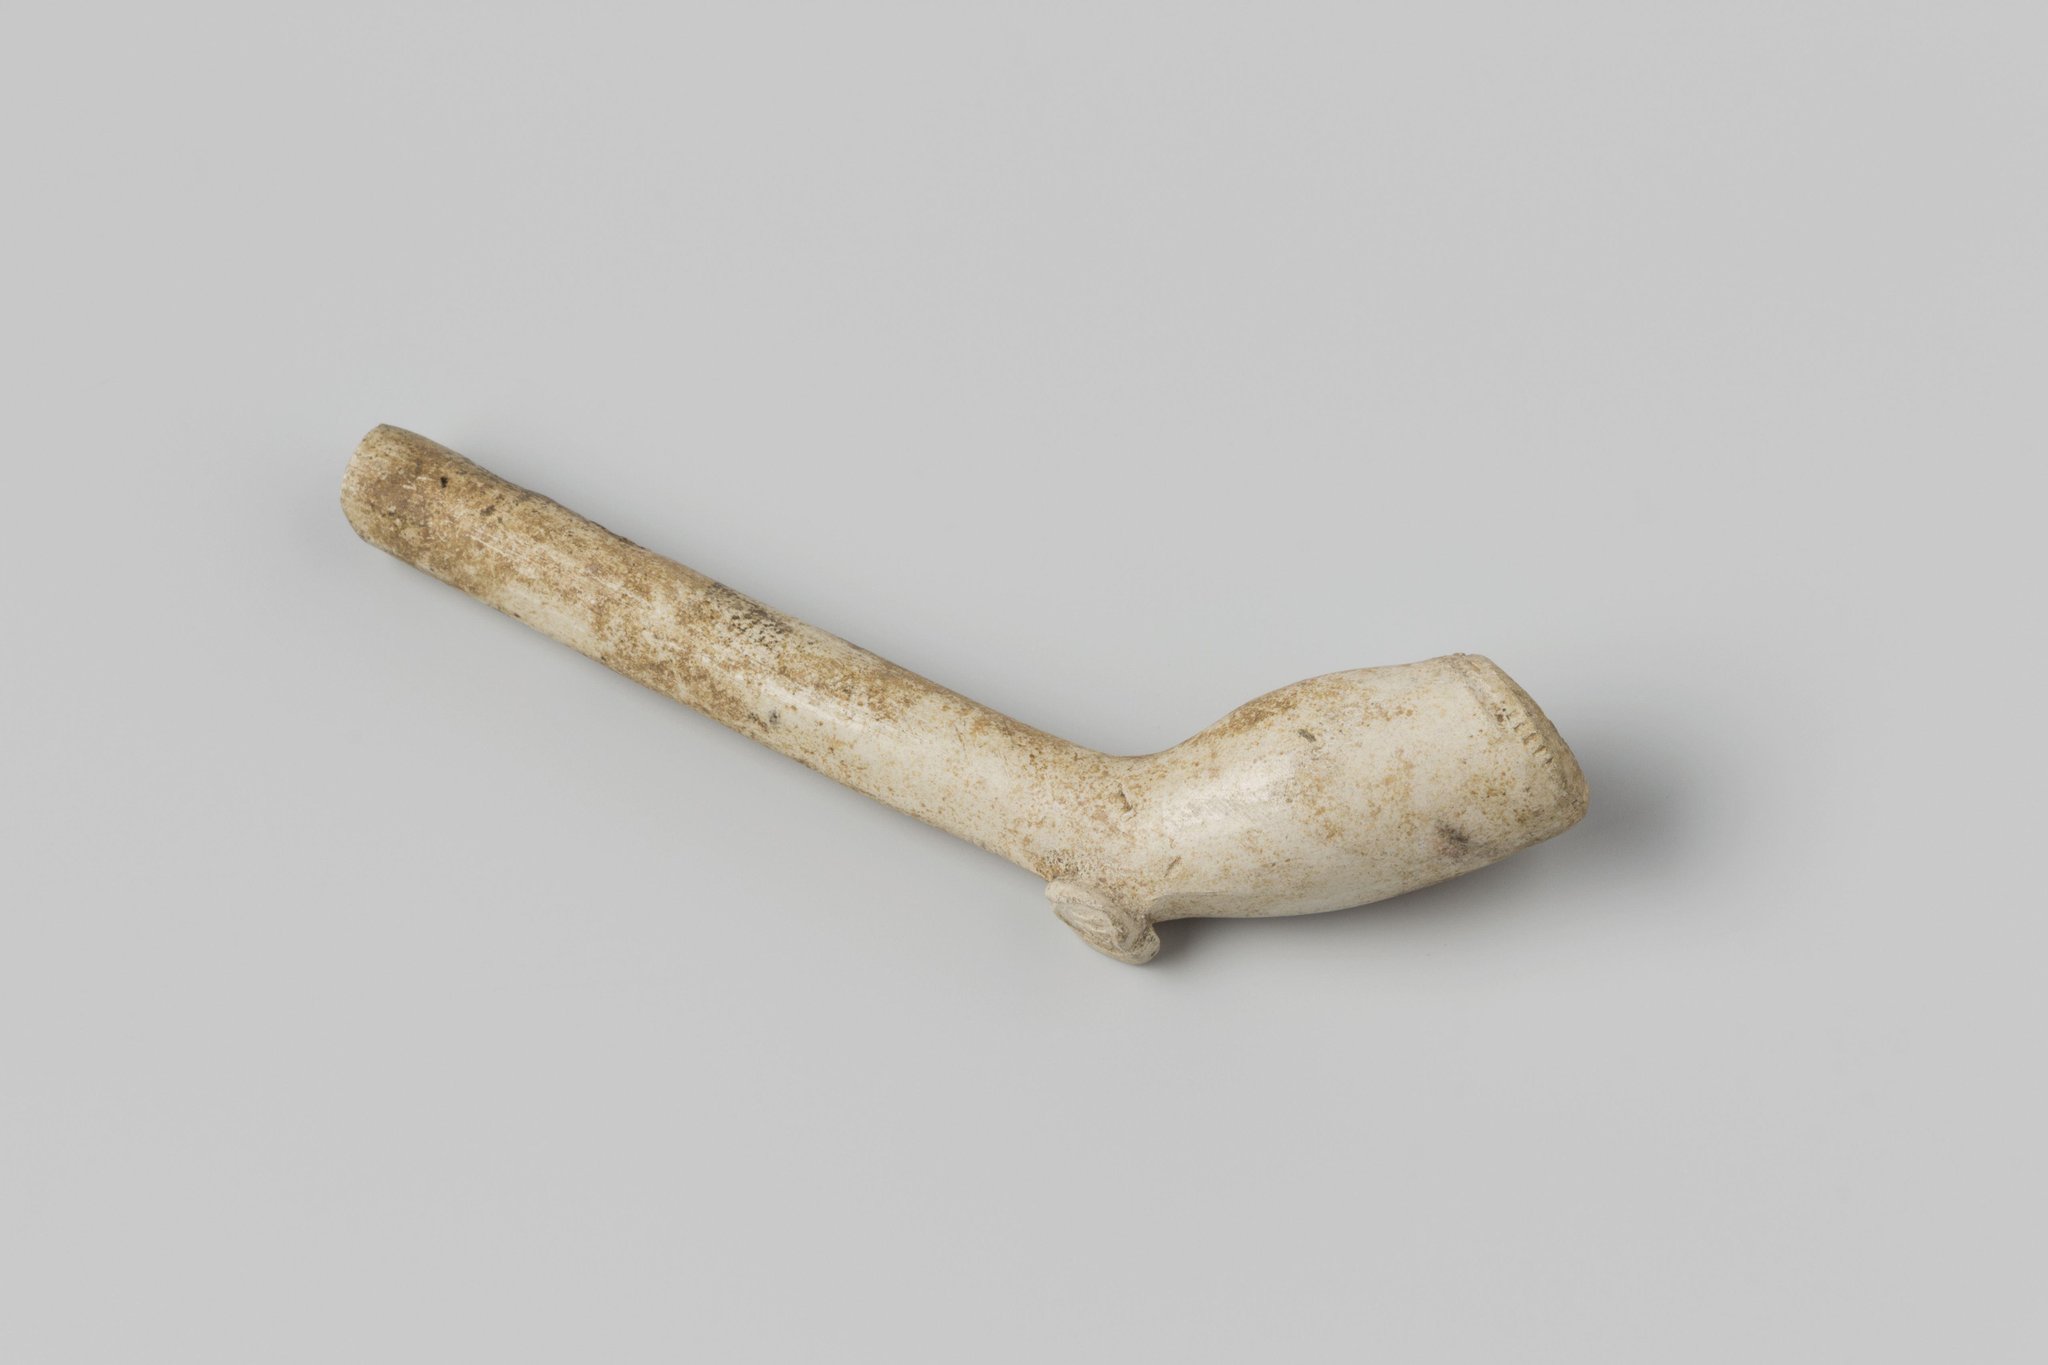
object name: pipe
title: Pijp van witte aarde met losangefiguren met daarin twee lelies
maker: Anonymous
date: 1400-1950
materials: earthenware, clay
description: Pijp van witte aarde met losangefiguren met daarin twee lelies.